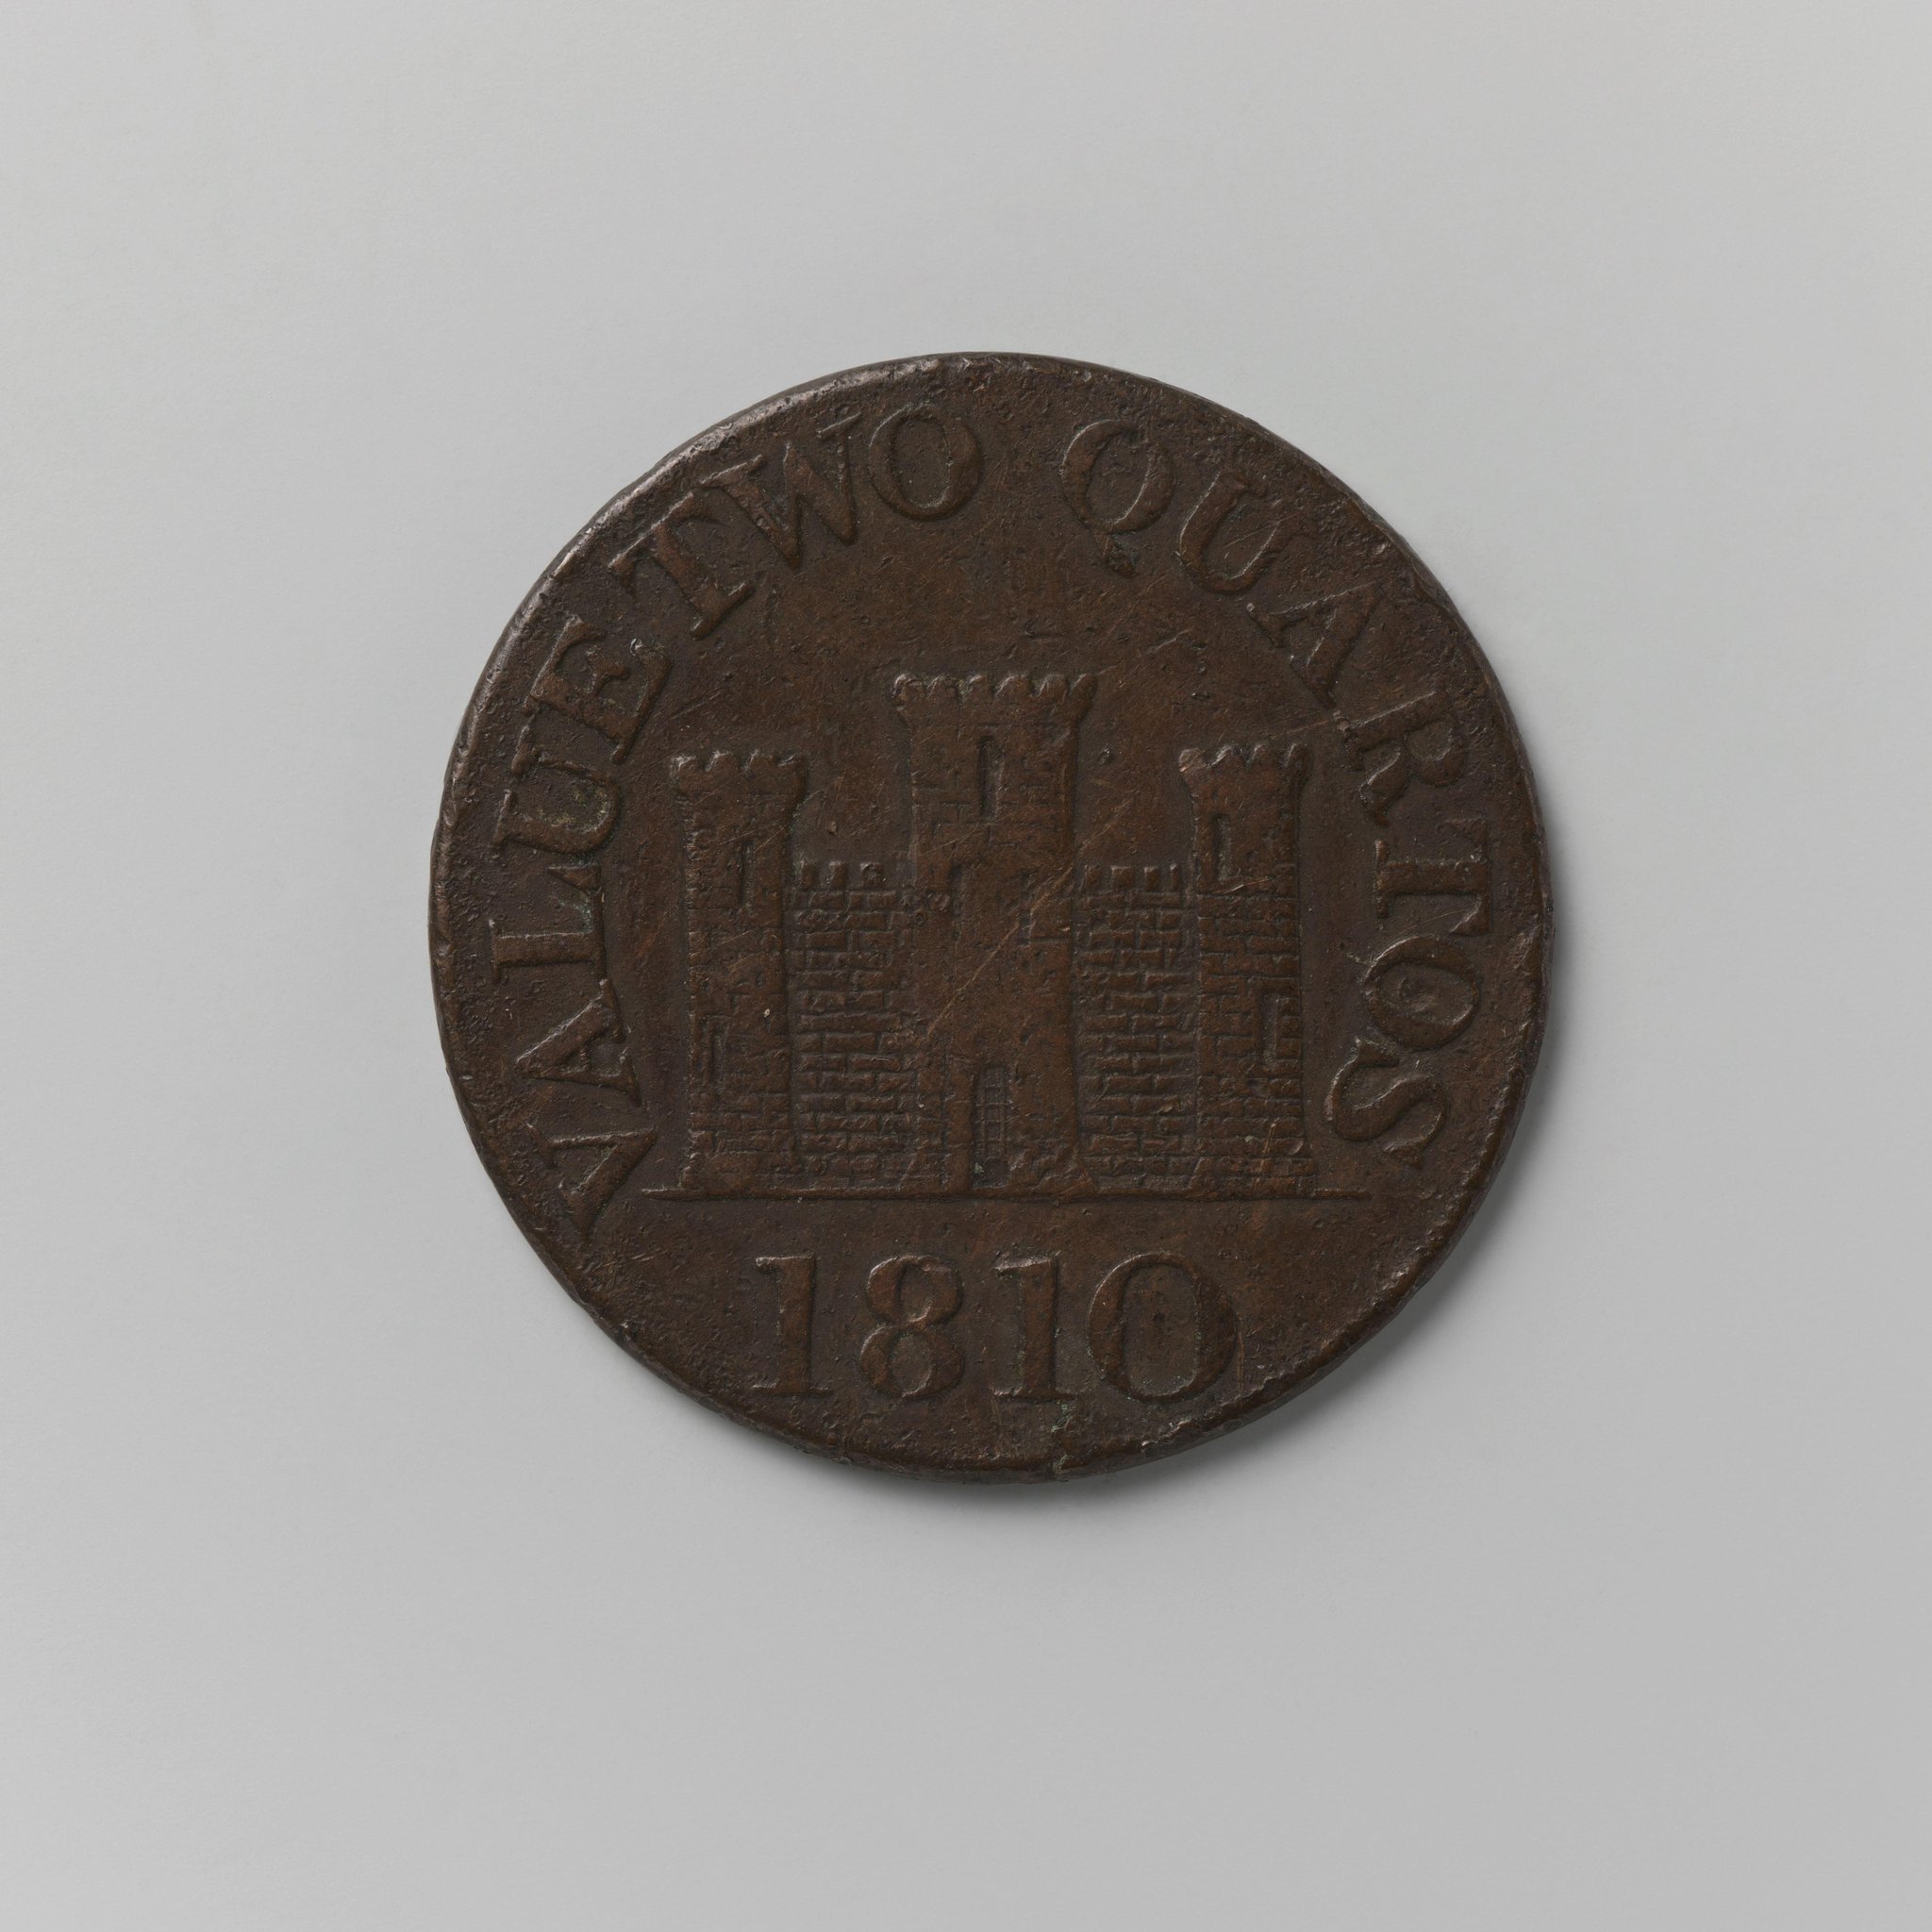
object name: coin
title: 2 quartos uit Gibraltar, 1810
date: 1810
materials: copper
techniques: striking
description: Koperen particuliere munt. Voorzijde: zittende leeuw naar links, in rechterklauw sleutel. Keerzijde: kasteel, waaronder jaartal. Waarde-aanduiding in omschrft. Gladde rand.